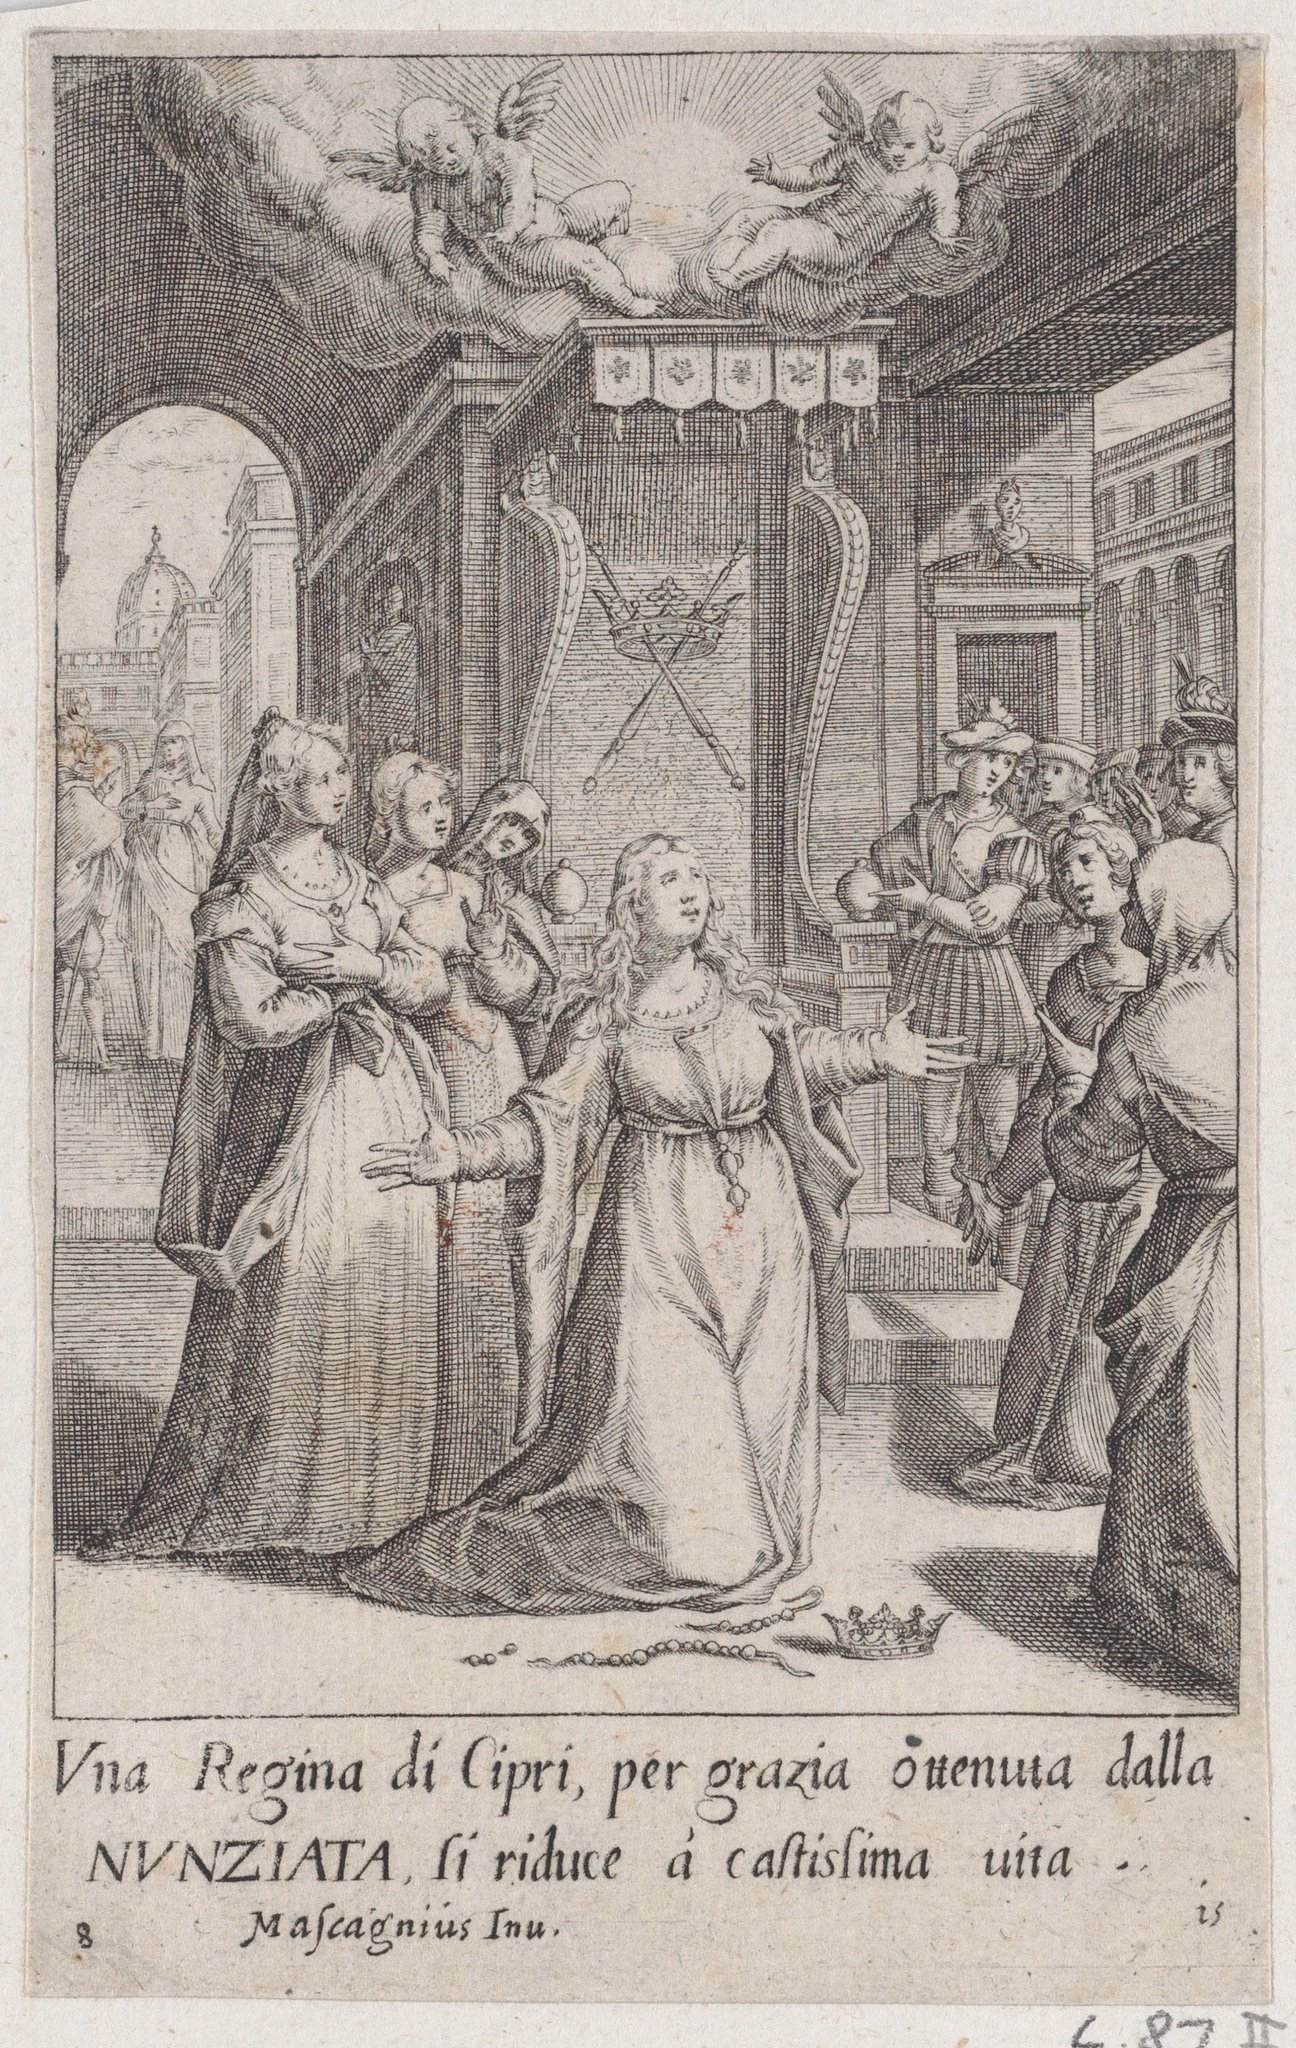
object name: print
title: The Queen of Cyprus, from Scelta d'Alcuni Miracoli e Grazie della Santissima Nunziata di Firenze (Selection of Some Miracles and Graces that Occurred in the Church of the Annunziata in Florence)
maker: jacques callot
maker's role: artist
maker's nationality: french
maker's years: 1592-1635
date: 1611-1619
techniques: engraving